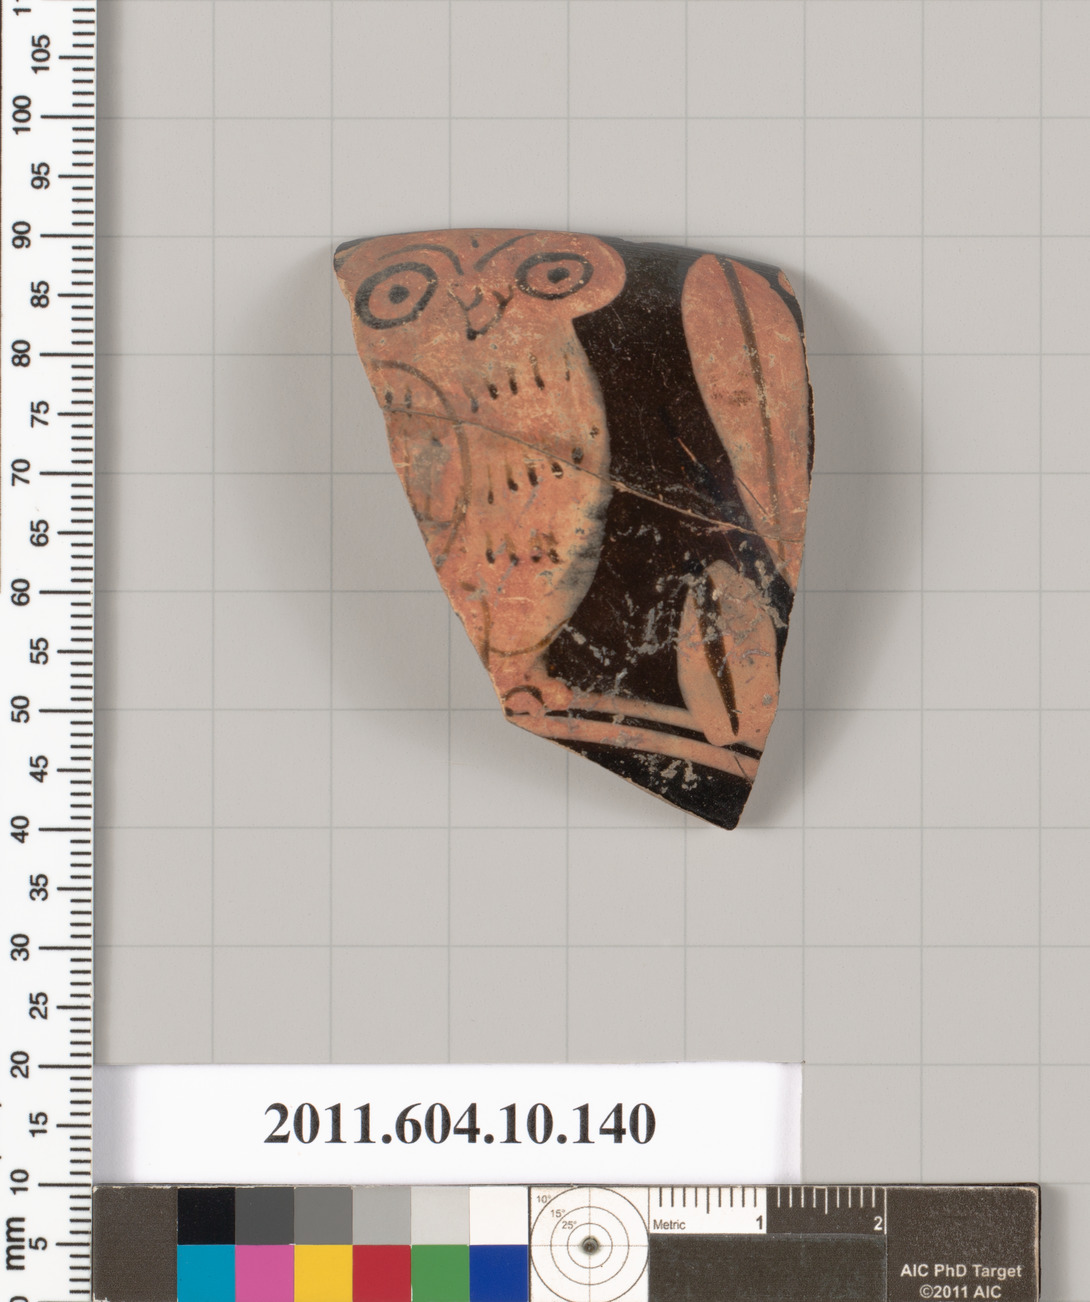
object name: skyphos fragment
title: Terracotta fragment of a skyphos (deep drinking cup)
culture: etruscan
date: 434-401 BCE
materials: terracotta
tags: owls